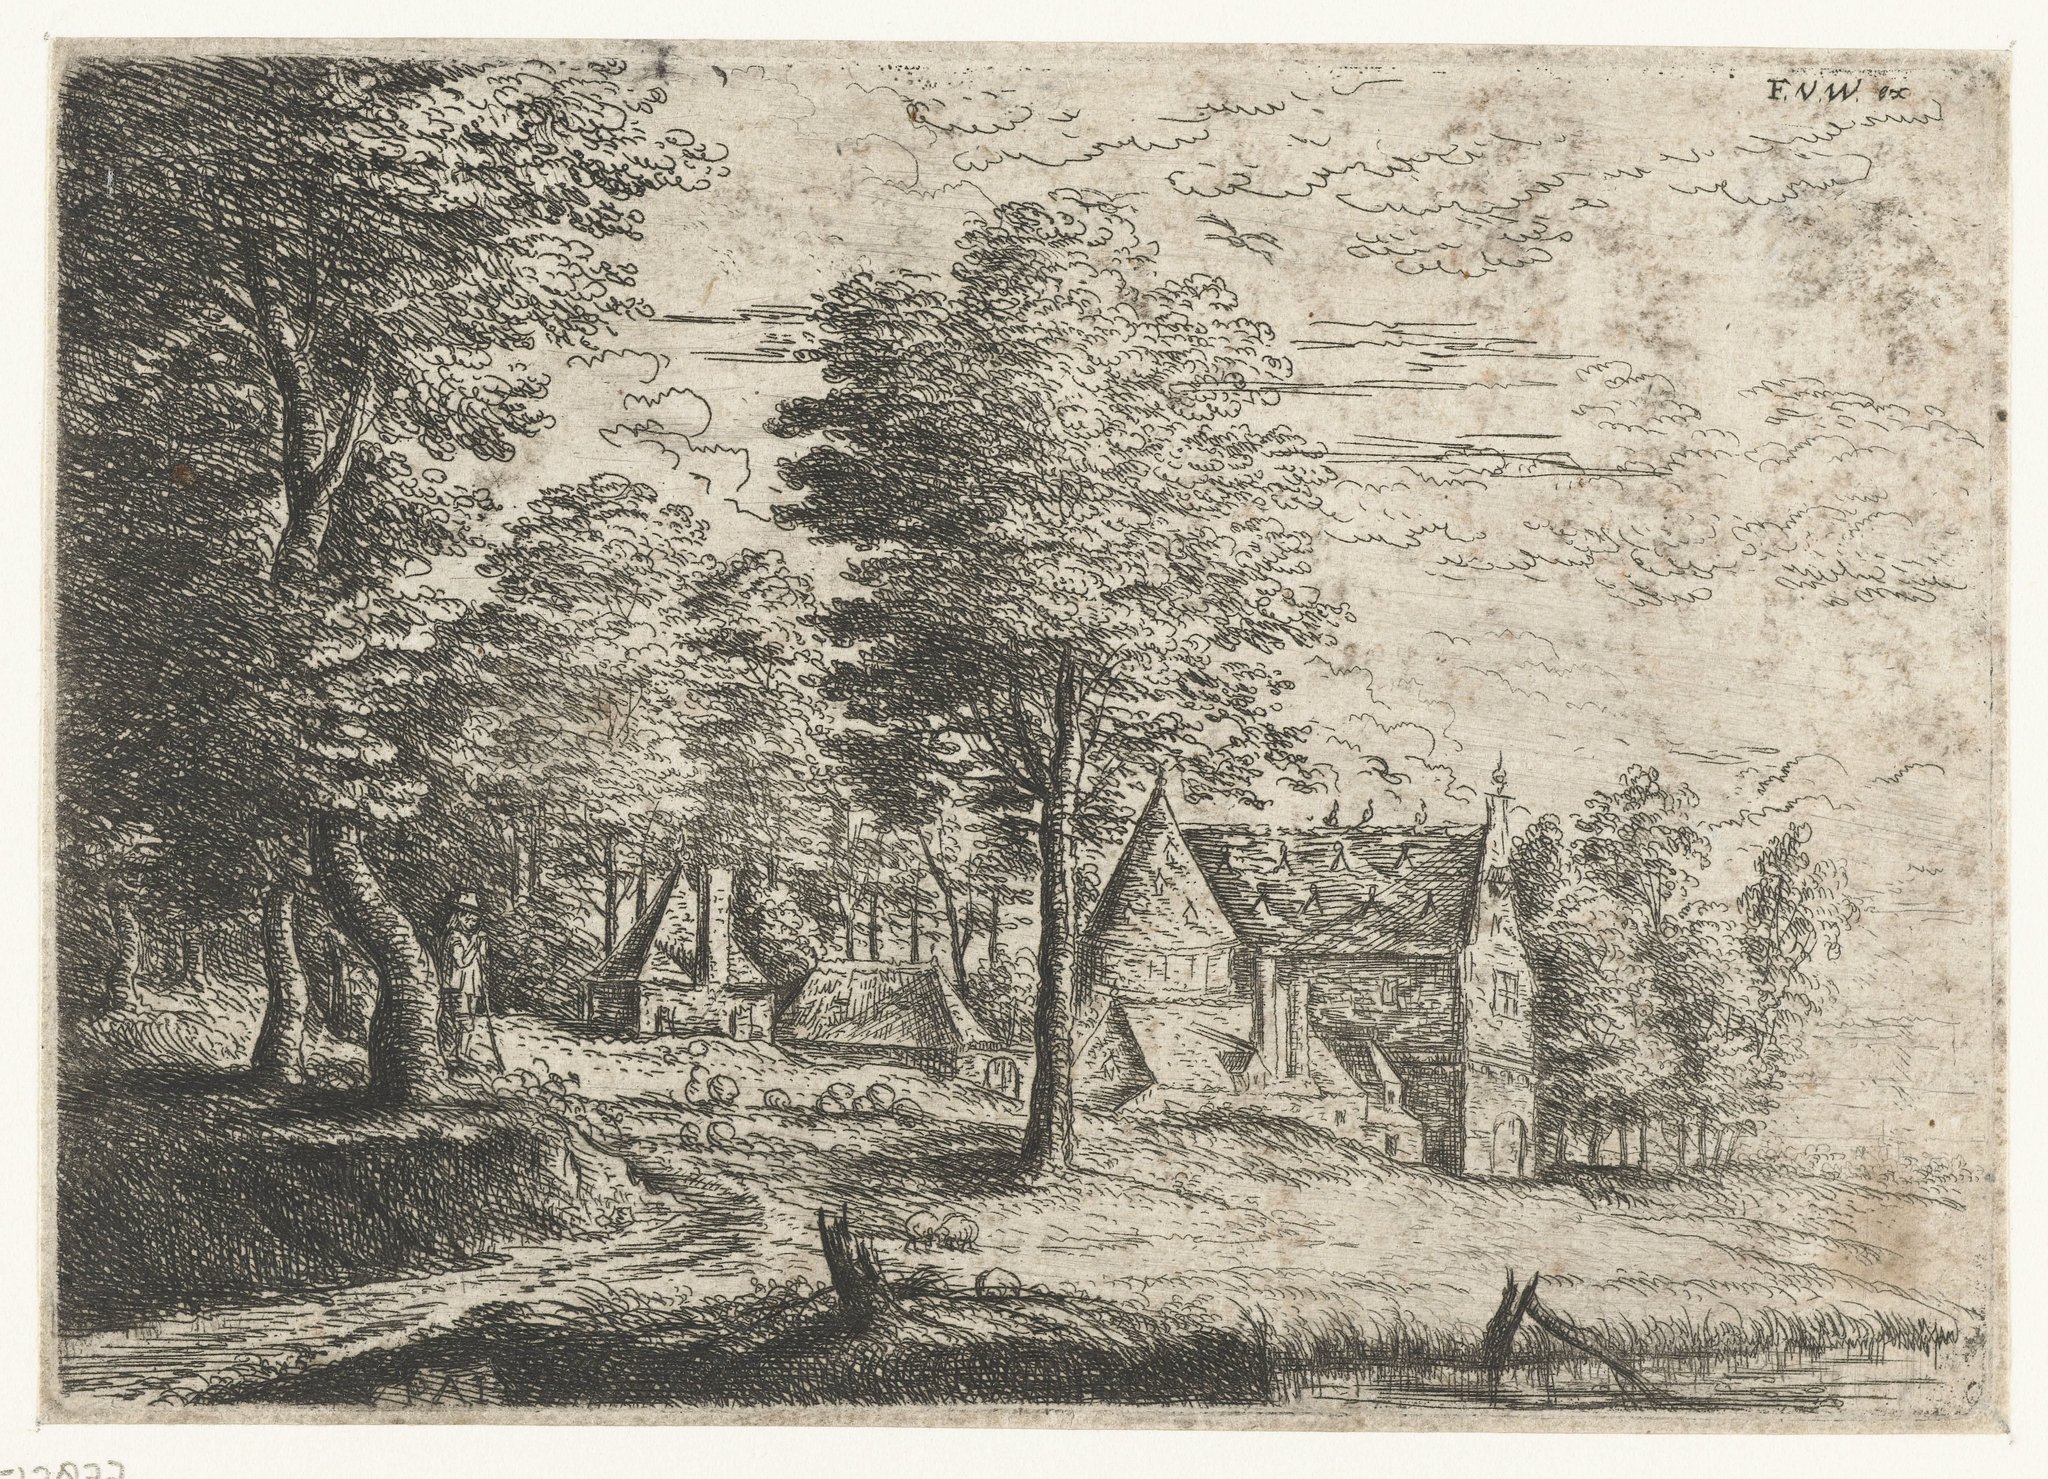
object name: print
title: Landschap met een herder en zijn kudde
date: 1637-1679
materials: paper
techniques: engraving, etching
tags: herding, herdsman, herdswoman, shepherd, shepherdess, cowherd, etc., sheep, country-house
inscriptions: collector's mark: Lugt 1407, collector's mark: Lugt 2228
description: Landschap met een landhuis en een herder met zijn kudde.